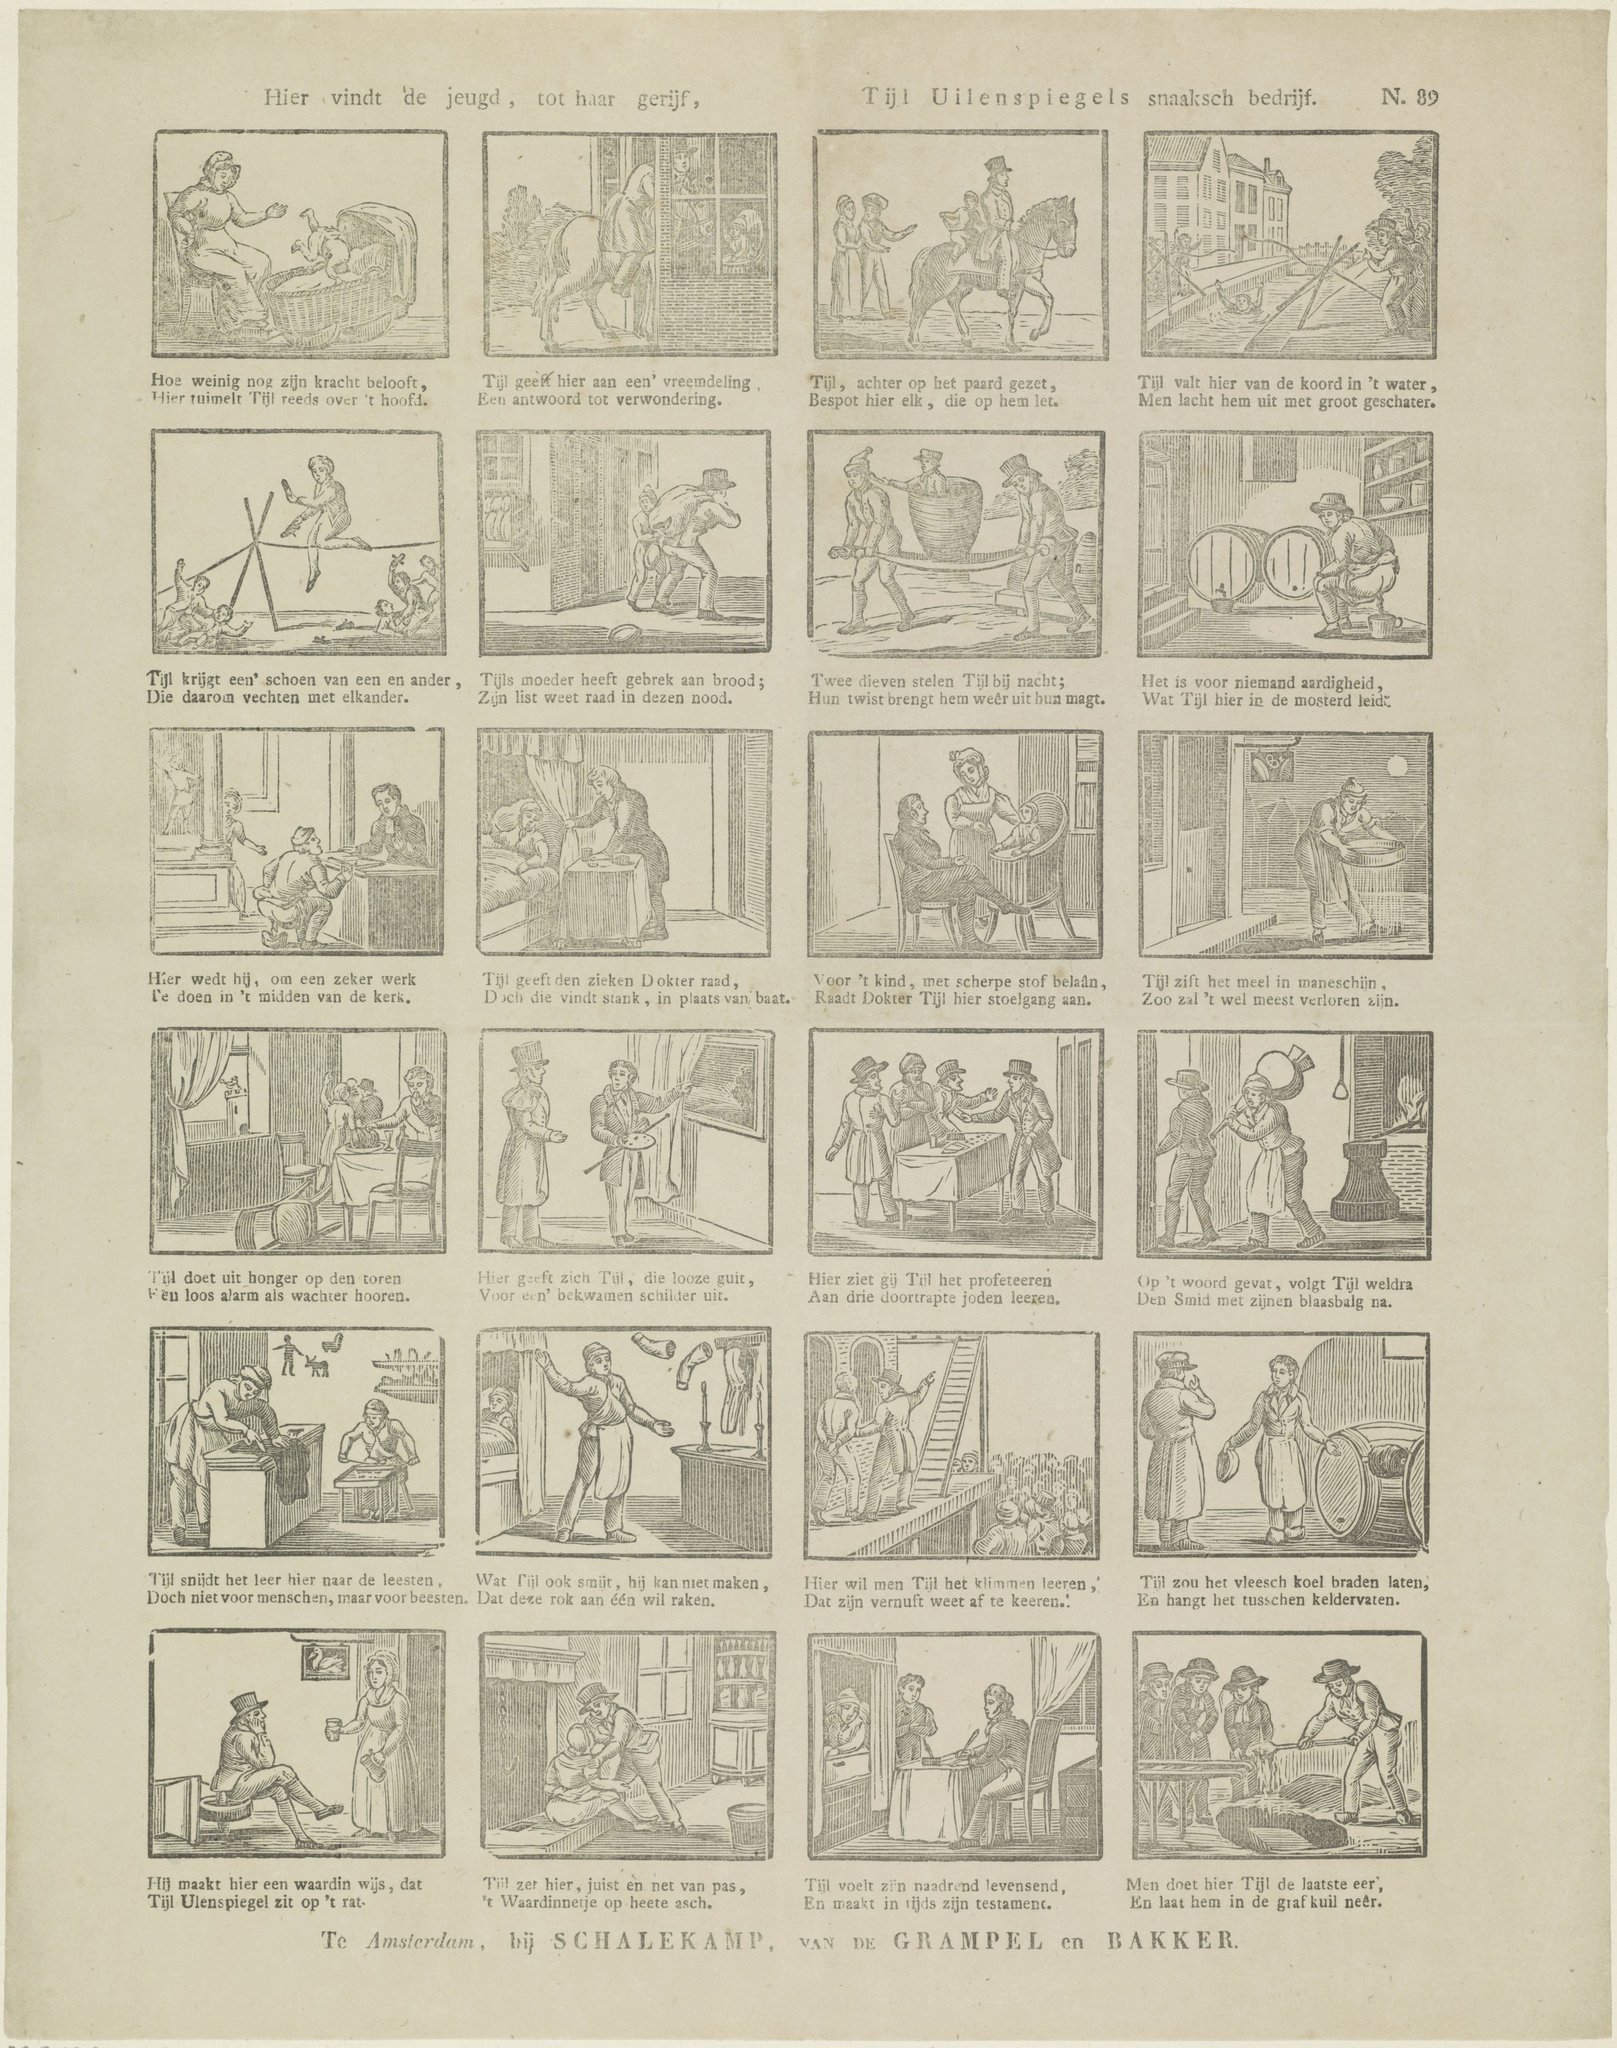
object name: popular print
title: Hier vindt de jeugd, tot haar gerijf, / Tijl Uilenspiegels snaaksch bedrijf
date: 1822-1849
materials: paper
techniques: letterpress printing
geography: amsterdam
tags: eulenspiegel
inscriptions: collector's mark: Lugt 2760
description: Blad met 24 voorstellingen over het leven van Tijl Uilenspiegel. Onder elke afbeelding een tweeregelig vers. Genummerd rechtsboven: N. 89.